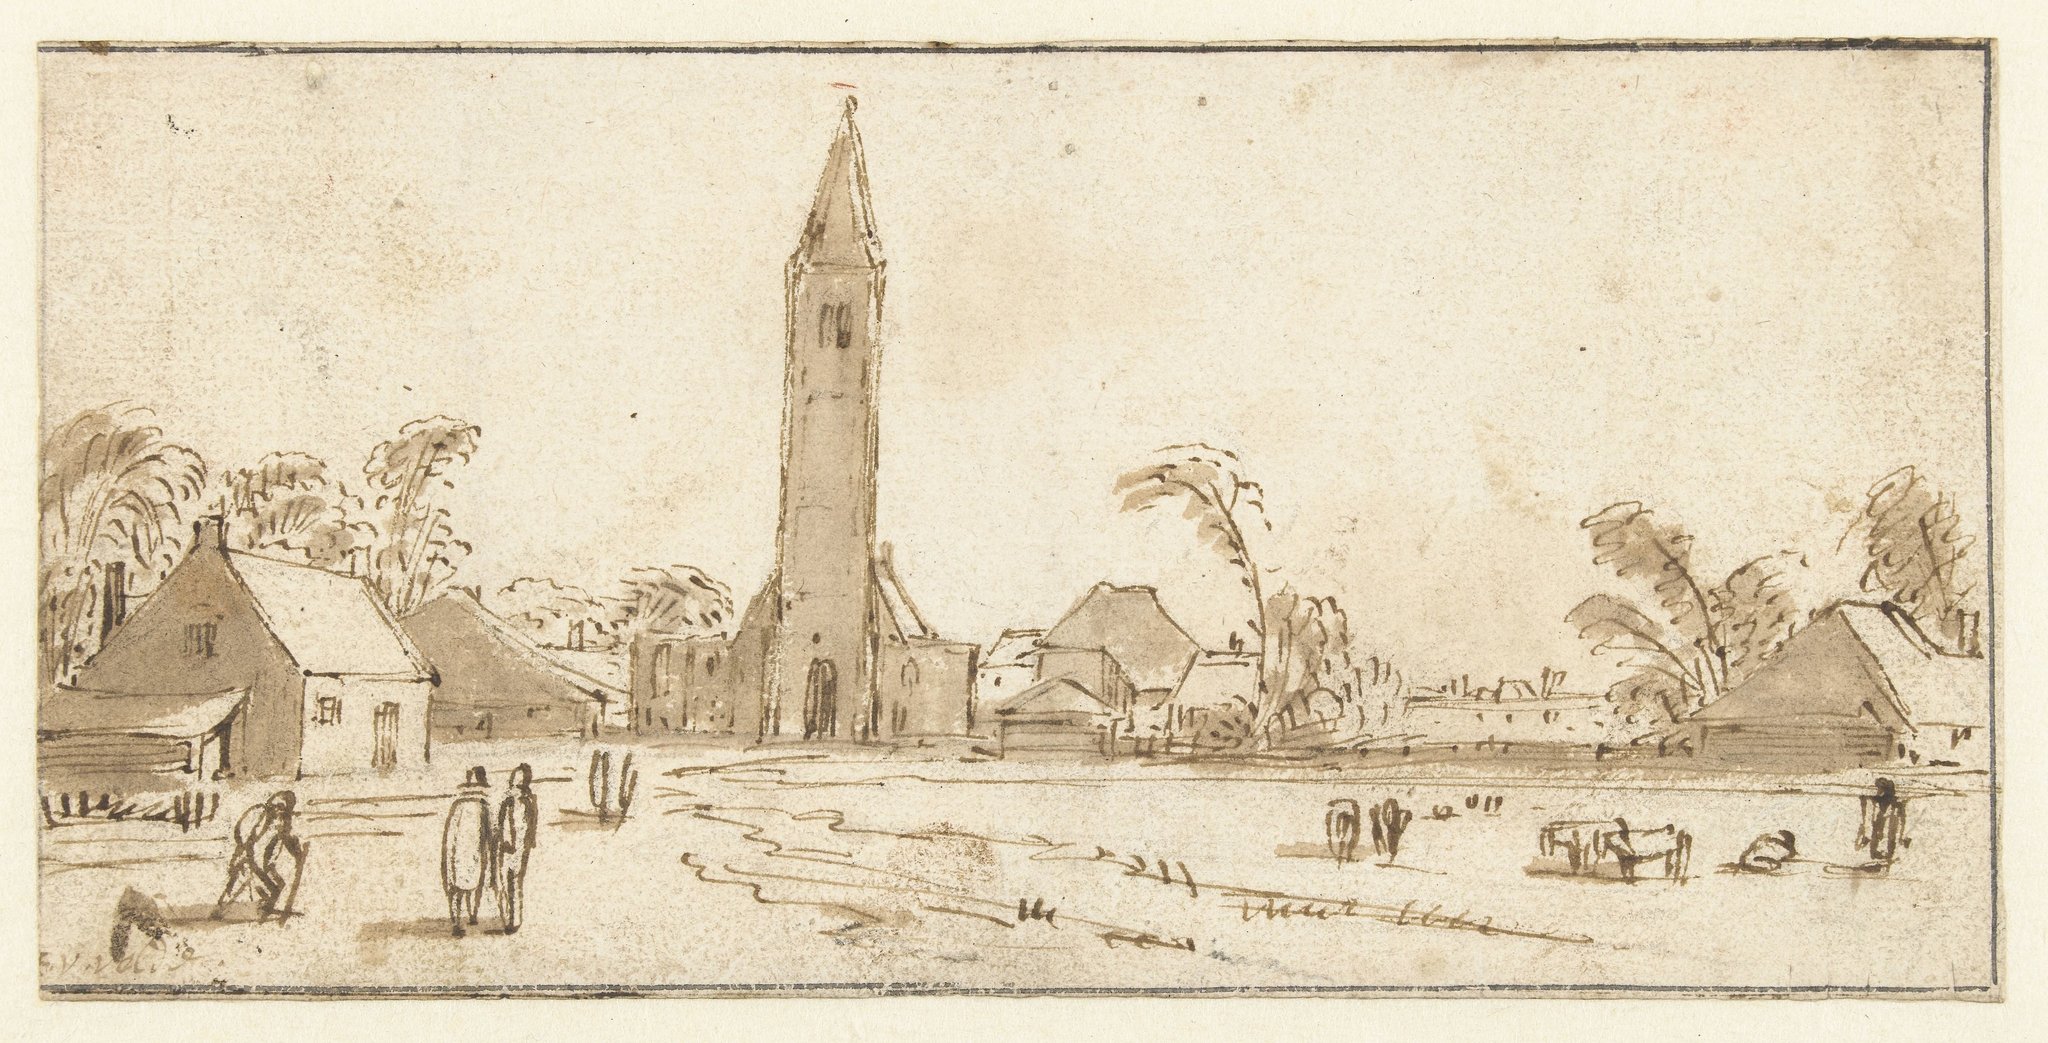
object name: design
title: Gezicht op Spaarnwoude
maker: esaias van de velde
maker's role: draughtsman, painter, print maker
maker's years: 1587-1630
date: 1610-1615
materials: chalk, ink, paper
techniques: brush, pen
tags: prospect of village, silhouette of village, church (exterior)